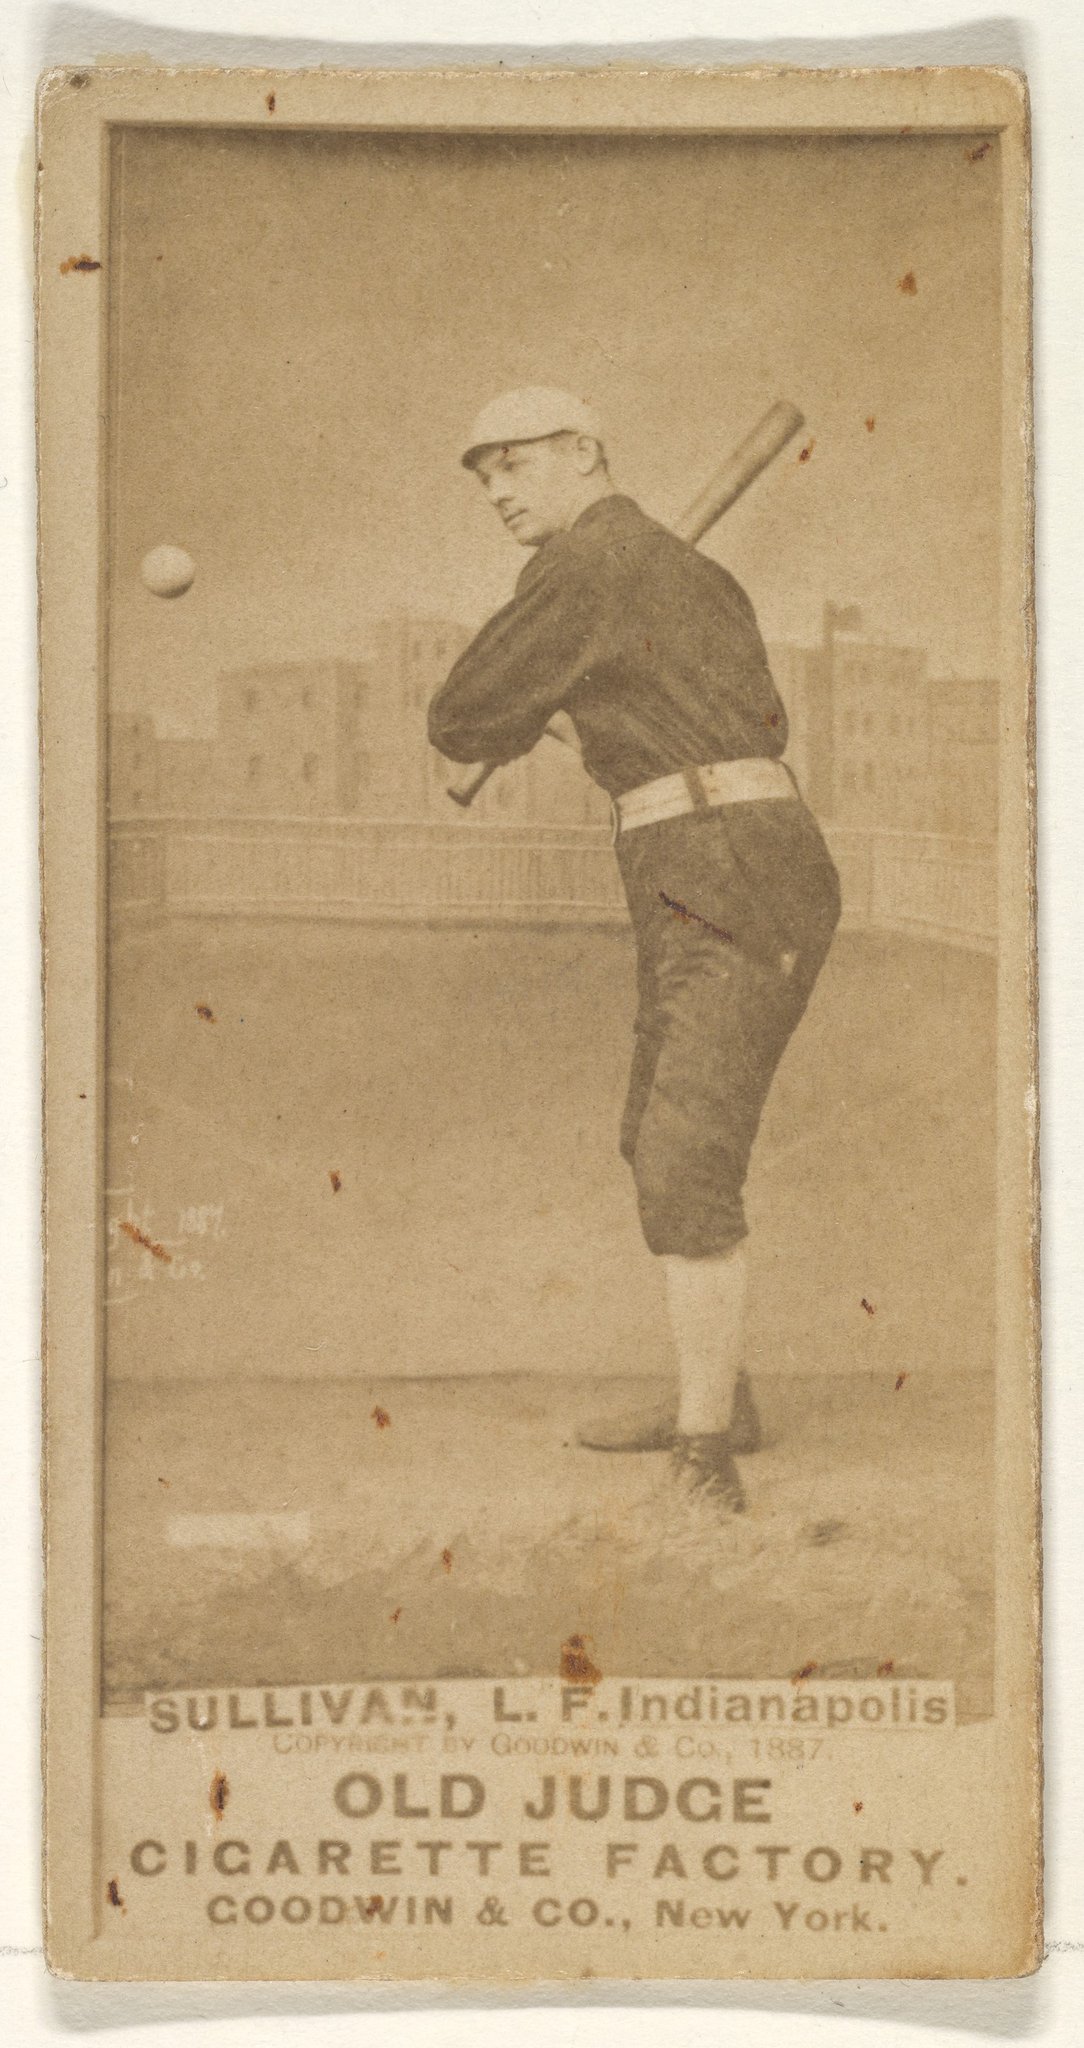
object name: baseball card, photograph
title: Sullivan, Left Field, Indianapolis, from the Old Judge series (N172) for Old Judge Cigarettes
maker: goodwin & company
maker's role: publisher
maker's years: 1850-1950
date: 1888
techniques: albumen silver print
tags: men,portraits,baseball,athletes